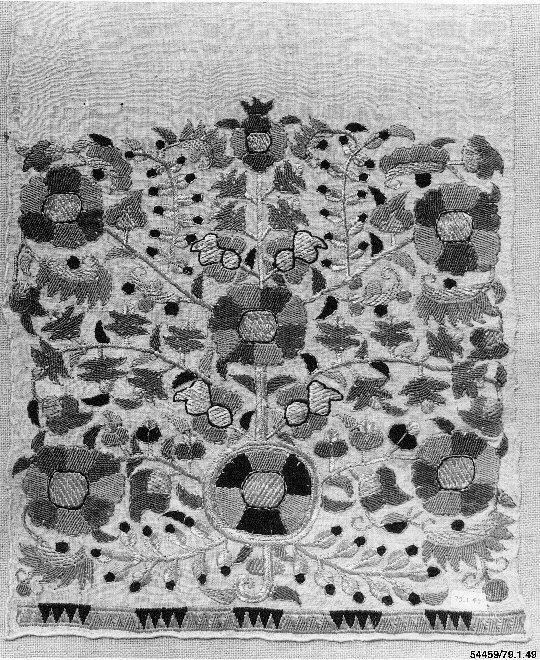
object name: towel end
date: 1801-1833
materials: linen, metal thread, silk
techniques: embroidery, weave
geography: turkey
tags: flowers